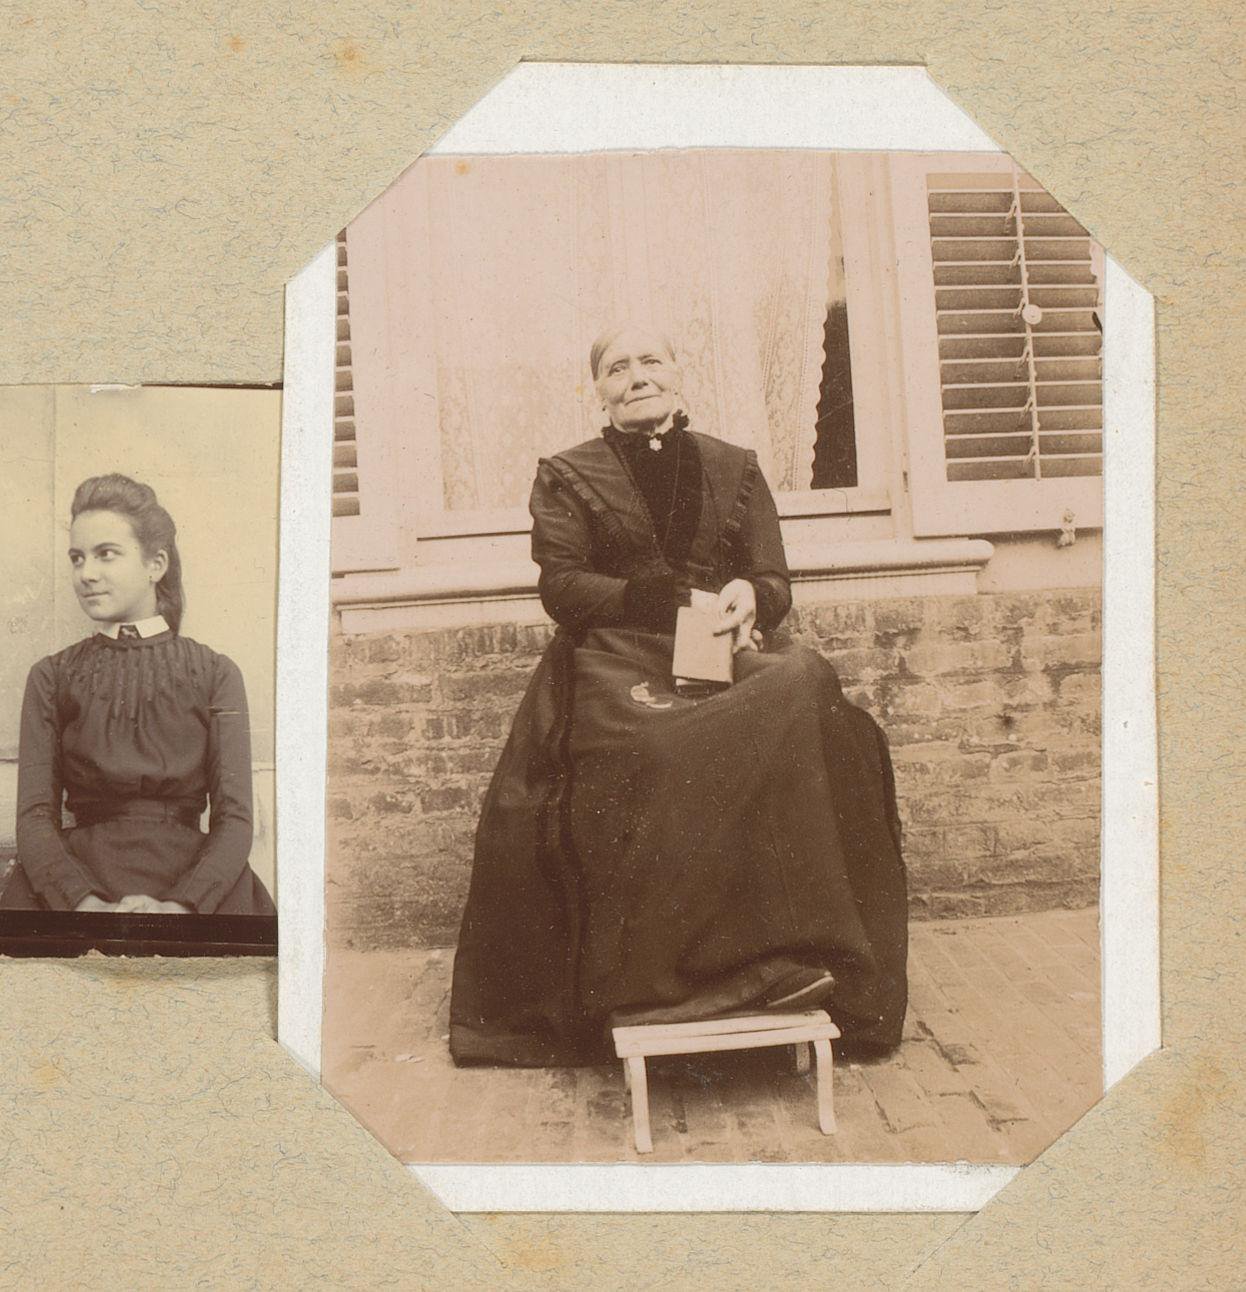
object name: album leaf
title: Portret van een oude vrouw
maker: Anonymous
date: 1897-1900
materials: paper, cardboard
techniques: gelatin silver print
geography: france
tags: historical persons, old woman, france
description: Over de foto is een ander negatief afgedrukt van een voorstelling van bomen.